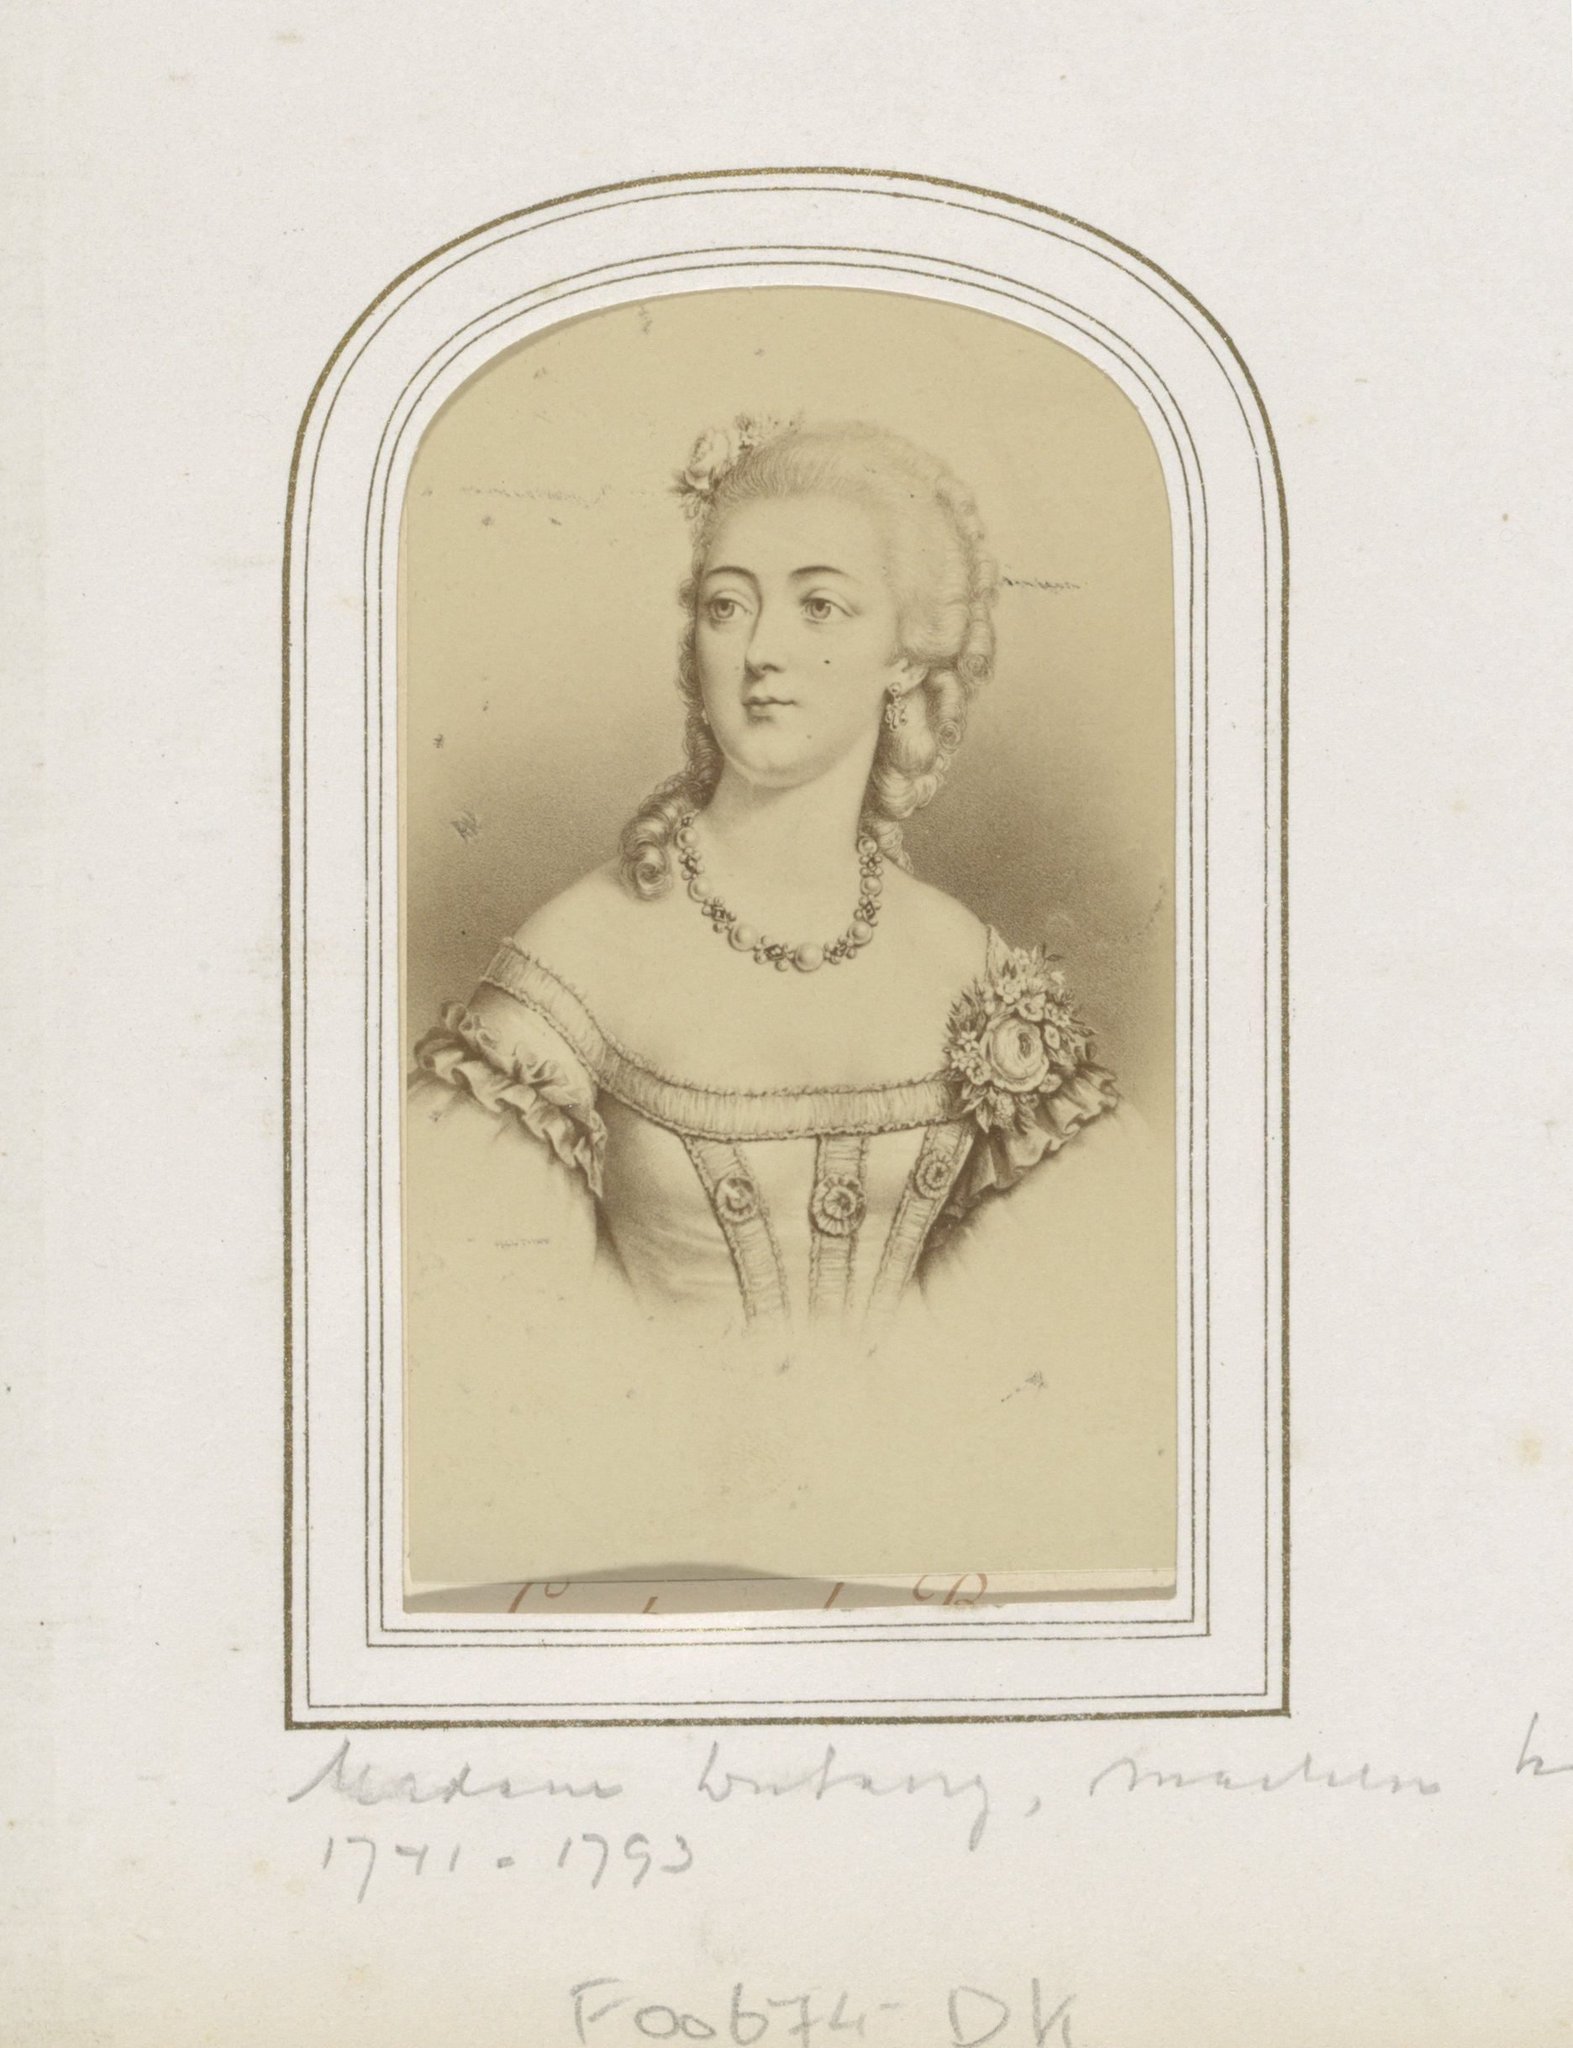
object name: carte de visite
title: Fotoreproductie van (vermoedelijk) een prent van Madame du Barry, maîtresse van koning Lodewijk XV van Frankrijk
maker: étienne neurdein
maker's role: publisher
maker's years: 1832-1918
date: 1863-1880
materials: cardboard, paper, photographic support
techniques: albumen print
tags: corsage, historical persons, styles of hairdress - aa - ~ women, mistress, dress, gown, necklace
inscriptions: negative number: ‘464’, name: ‘ND. Phot.’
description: Onderdeel van Fotoalbum met 123 cartes-de-visite van leden van Europese vorstenhuizen, politici en bekende personen.